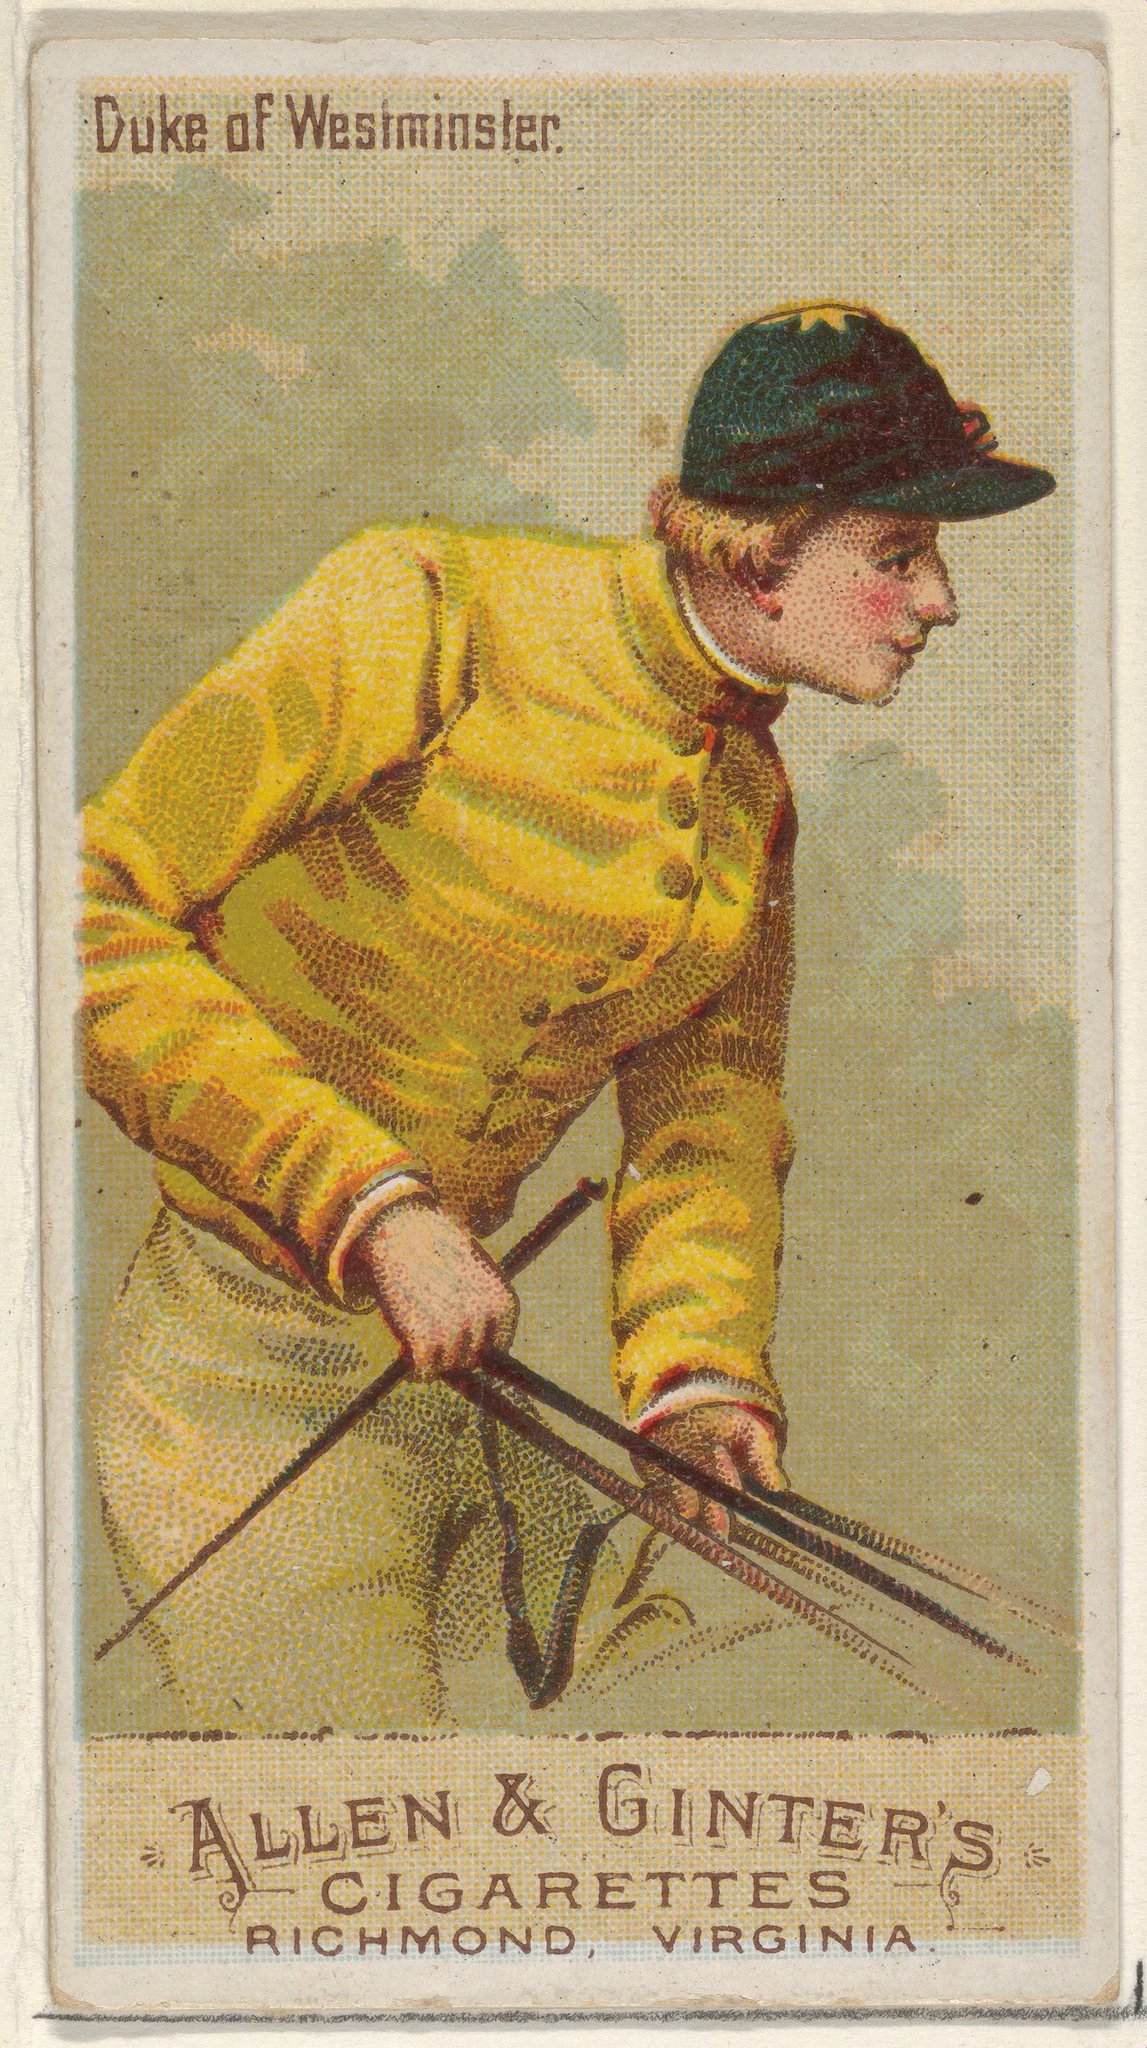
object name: print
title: Duke of Westminster, from the Racing Colors of the World series (N22a) for Allen & Ginter Cigarettes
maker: allen & ginter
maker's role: publisher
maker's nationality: american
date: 1888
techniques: color lithograph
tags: men,jockeys